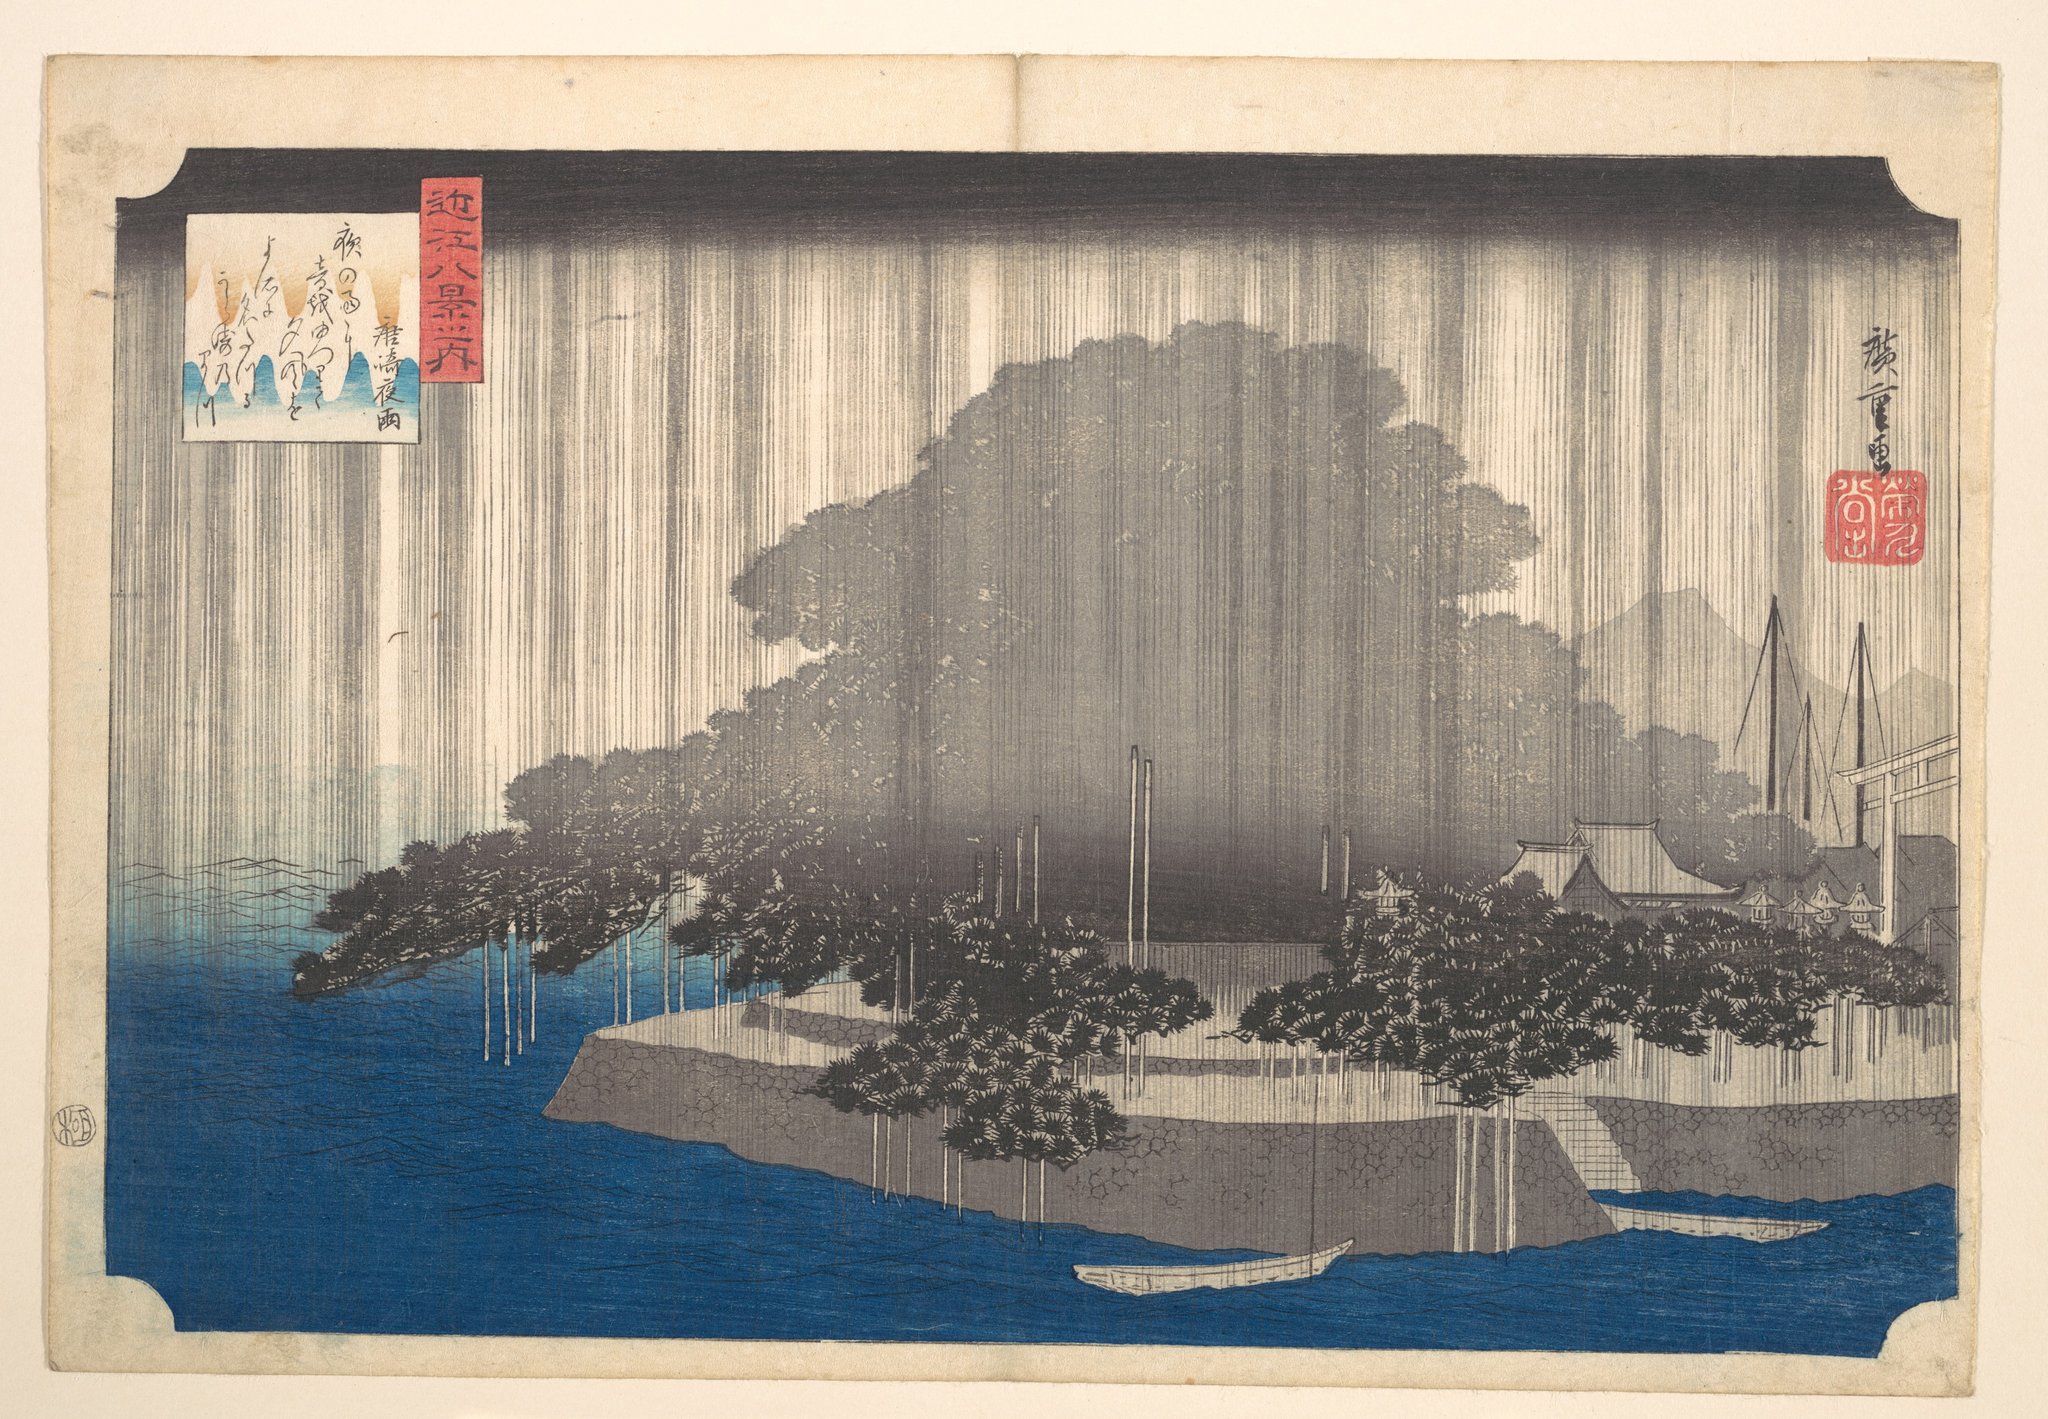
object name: print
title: Evening Rain at Karasaki-Pine Tree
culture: japanese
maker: utagawa hiroshige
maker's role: artist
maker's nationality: japanese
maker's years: 1797-1858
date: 1832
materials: ink, paper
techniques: woodblock print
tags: landscapes,trees,rain